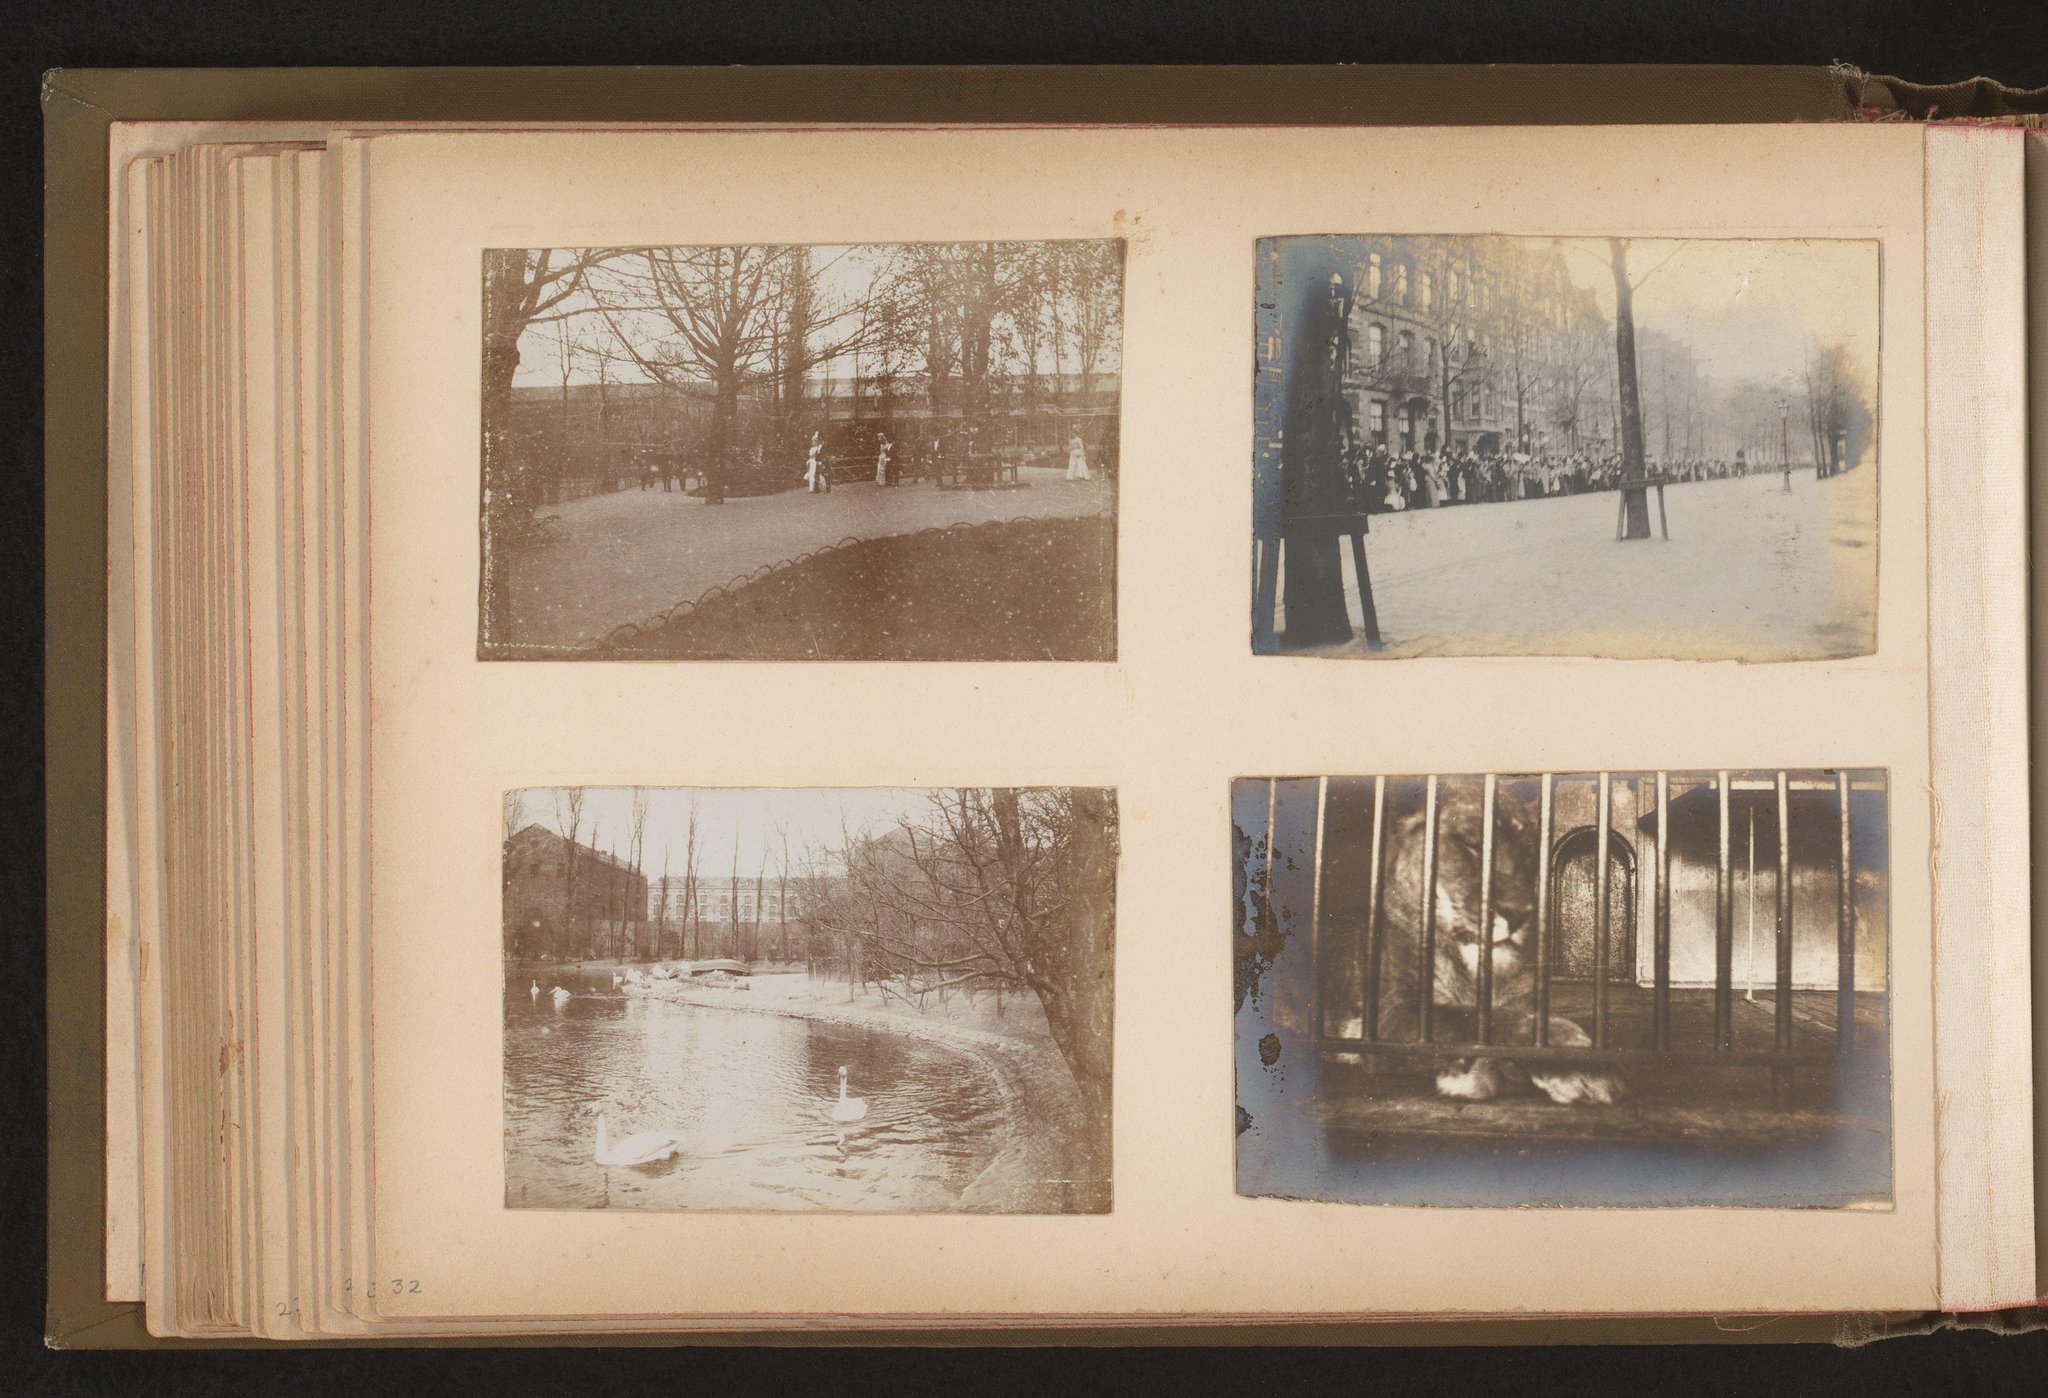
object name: album leaf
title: Vier foto's van dierentuin Artis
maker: Anonymous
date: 1895-1910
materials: paper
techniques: gelatin silver print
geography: amsterdam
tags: zoological garden, zoo, seen as place where non-domestic animals are kept, garden pond, beasts of prey, predatory animals: lion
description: Deze foto's maken deel uit van een album.